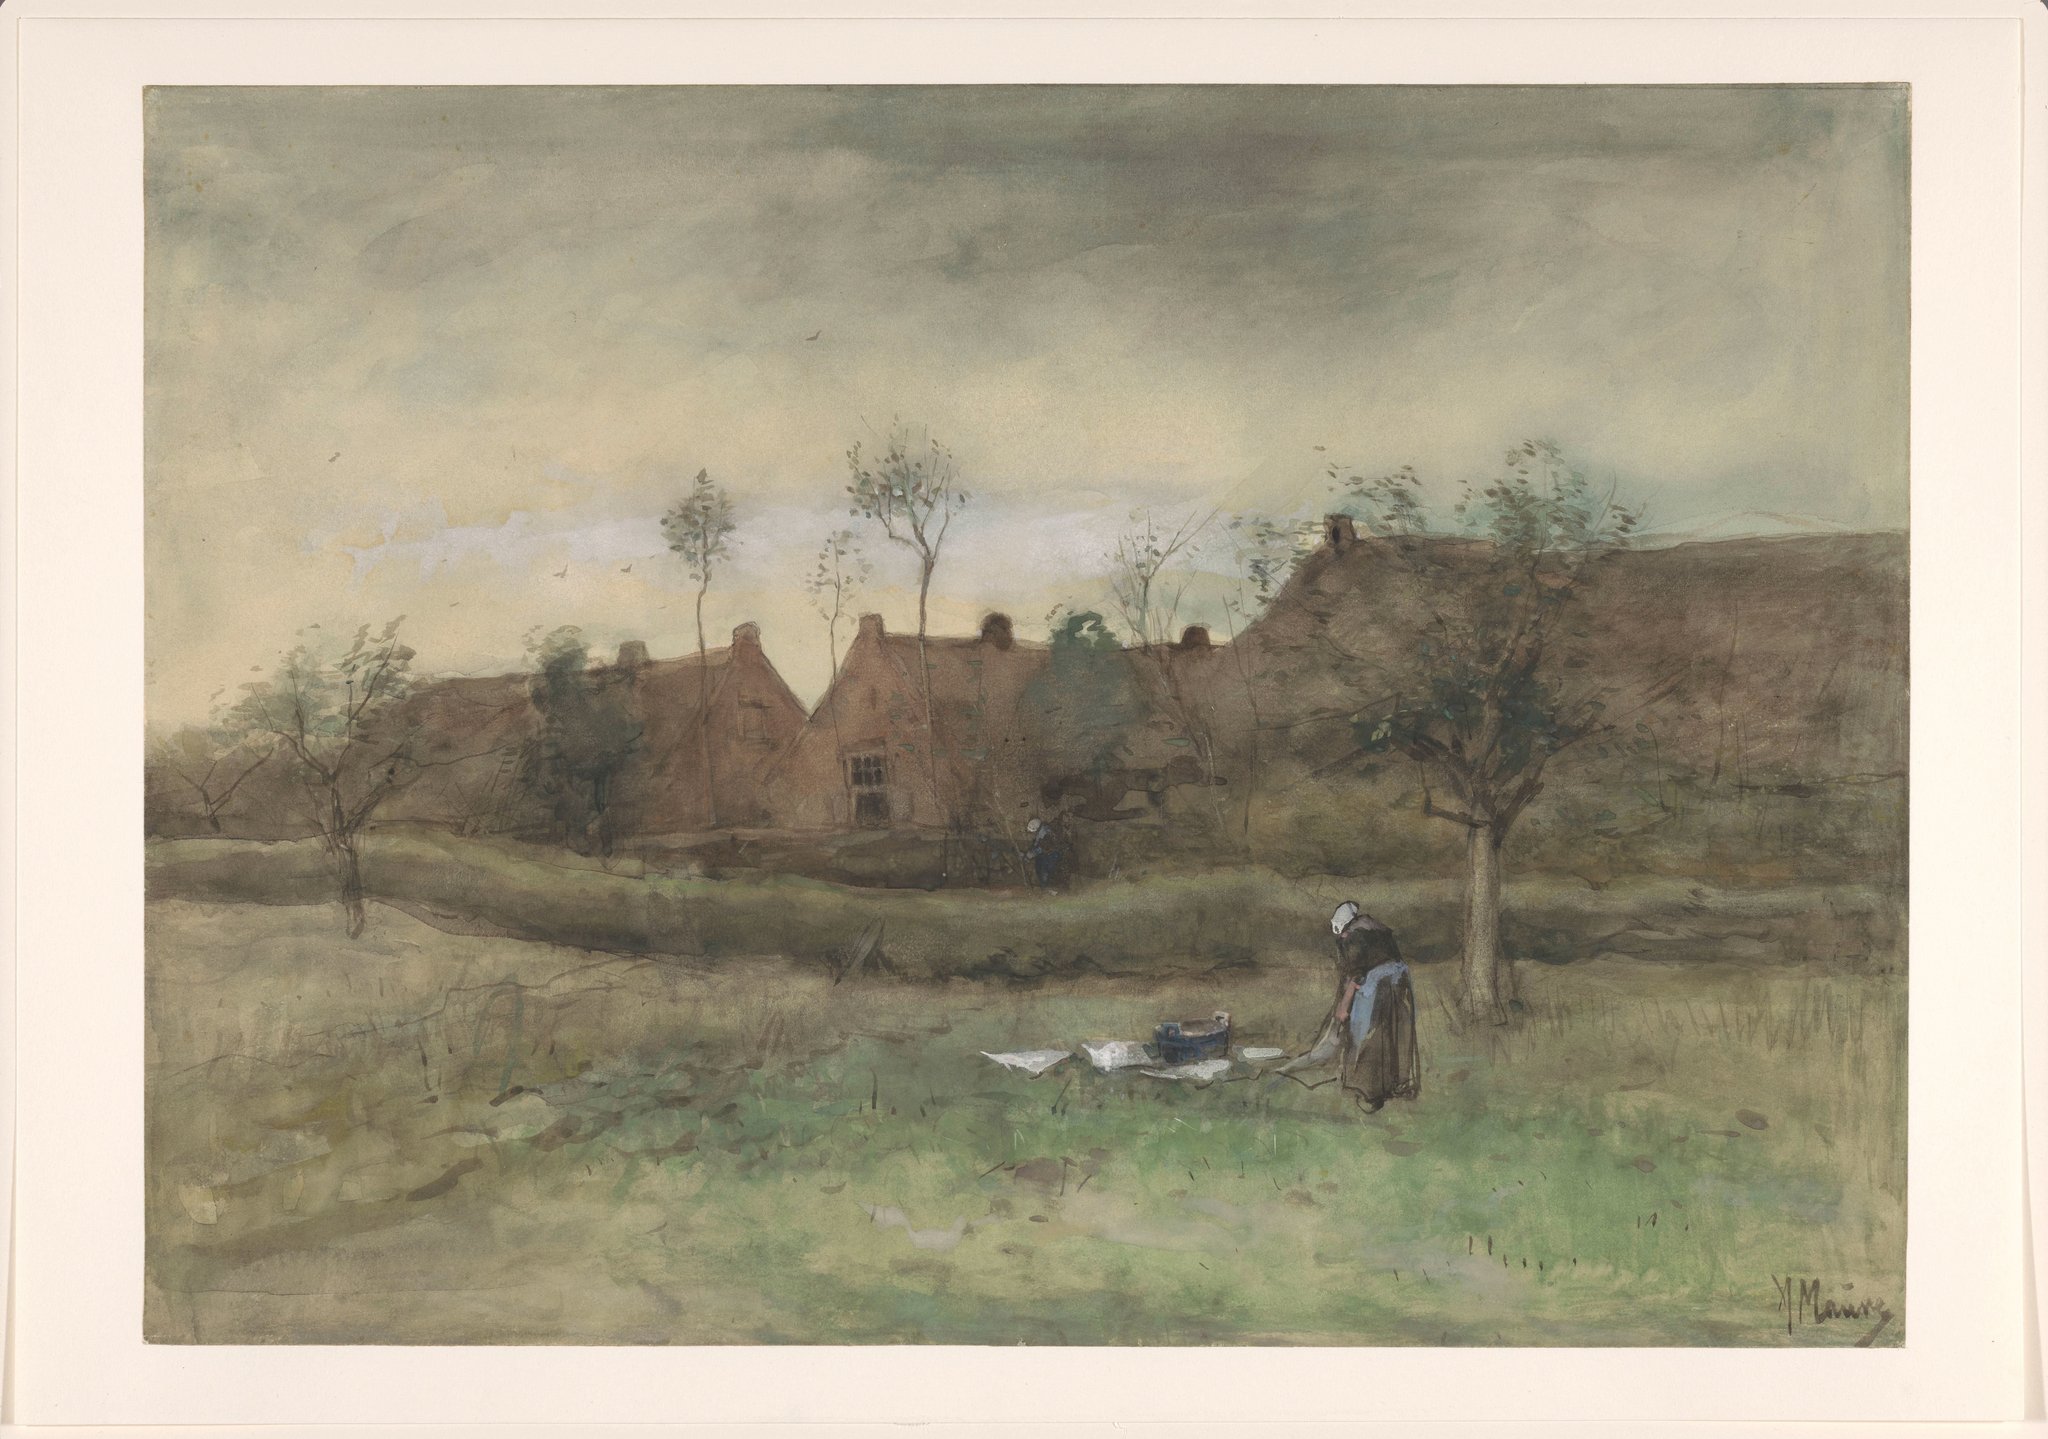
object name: painting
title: Sandy Path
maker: théophile de bock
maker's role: draughtsman, painter, print maker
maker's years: 1851-1904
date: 1870-1904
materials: canvas, oil, panel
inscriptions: signature: ‘Th. de Bock’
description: Landschap met een zandweg tussen geboomte. Links een stapel gekapt hout.